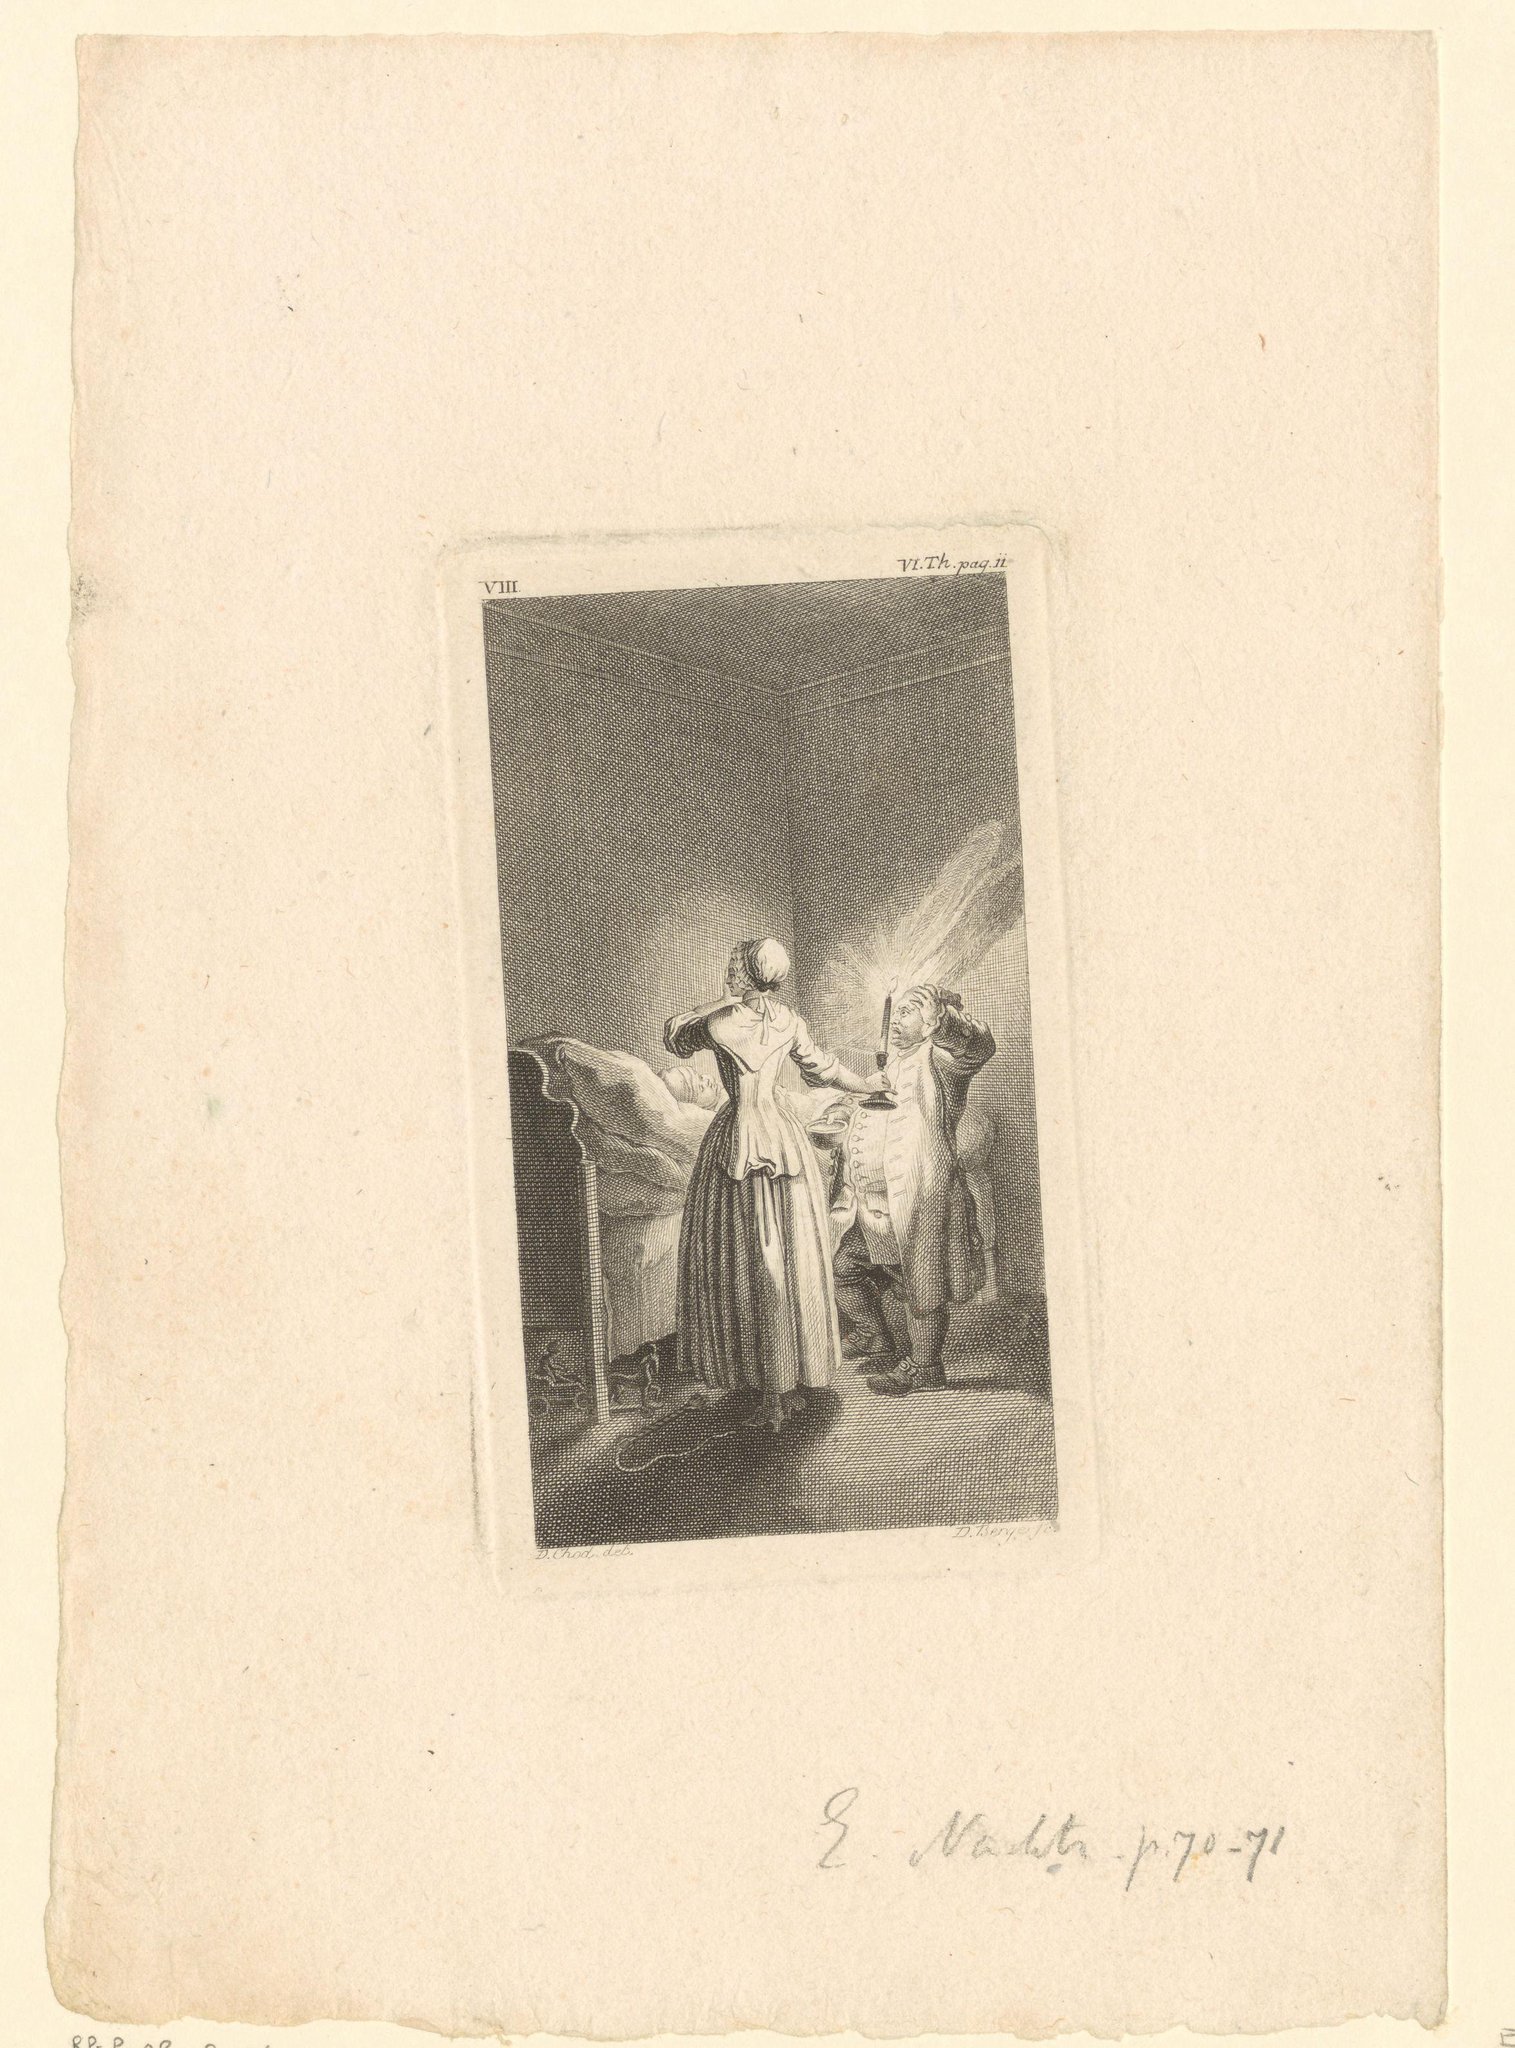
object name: print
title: Susannah steekt de pruik van dokter Slop in brand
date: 1778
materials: paper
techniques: etching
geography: berlin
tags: london, clergyman, accidental death ~ fire, literary characters and objects, wig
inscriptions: collector's mark: Lugt 240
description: Achtste prent uit de serie 'XII Kupfer zu den Leben und Meynungen Tristram Shandy's', bestaand uit een titelpagina en 12 prenten, gedrukt op kosten van de Berlijnse boekhandelaar Christian Friedrich Himburg in 1778. De illustraties volgen een eerder verschenen tekstuitgave: [Stern, Laurence]. Tristram Schandis Leben und Meynungen [uit het Duits vertaald door] Johann Joachim Christoph Bode. 9 dln. Hamburg: Carl Ernst Bohn te Hamburg, 1776.